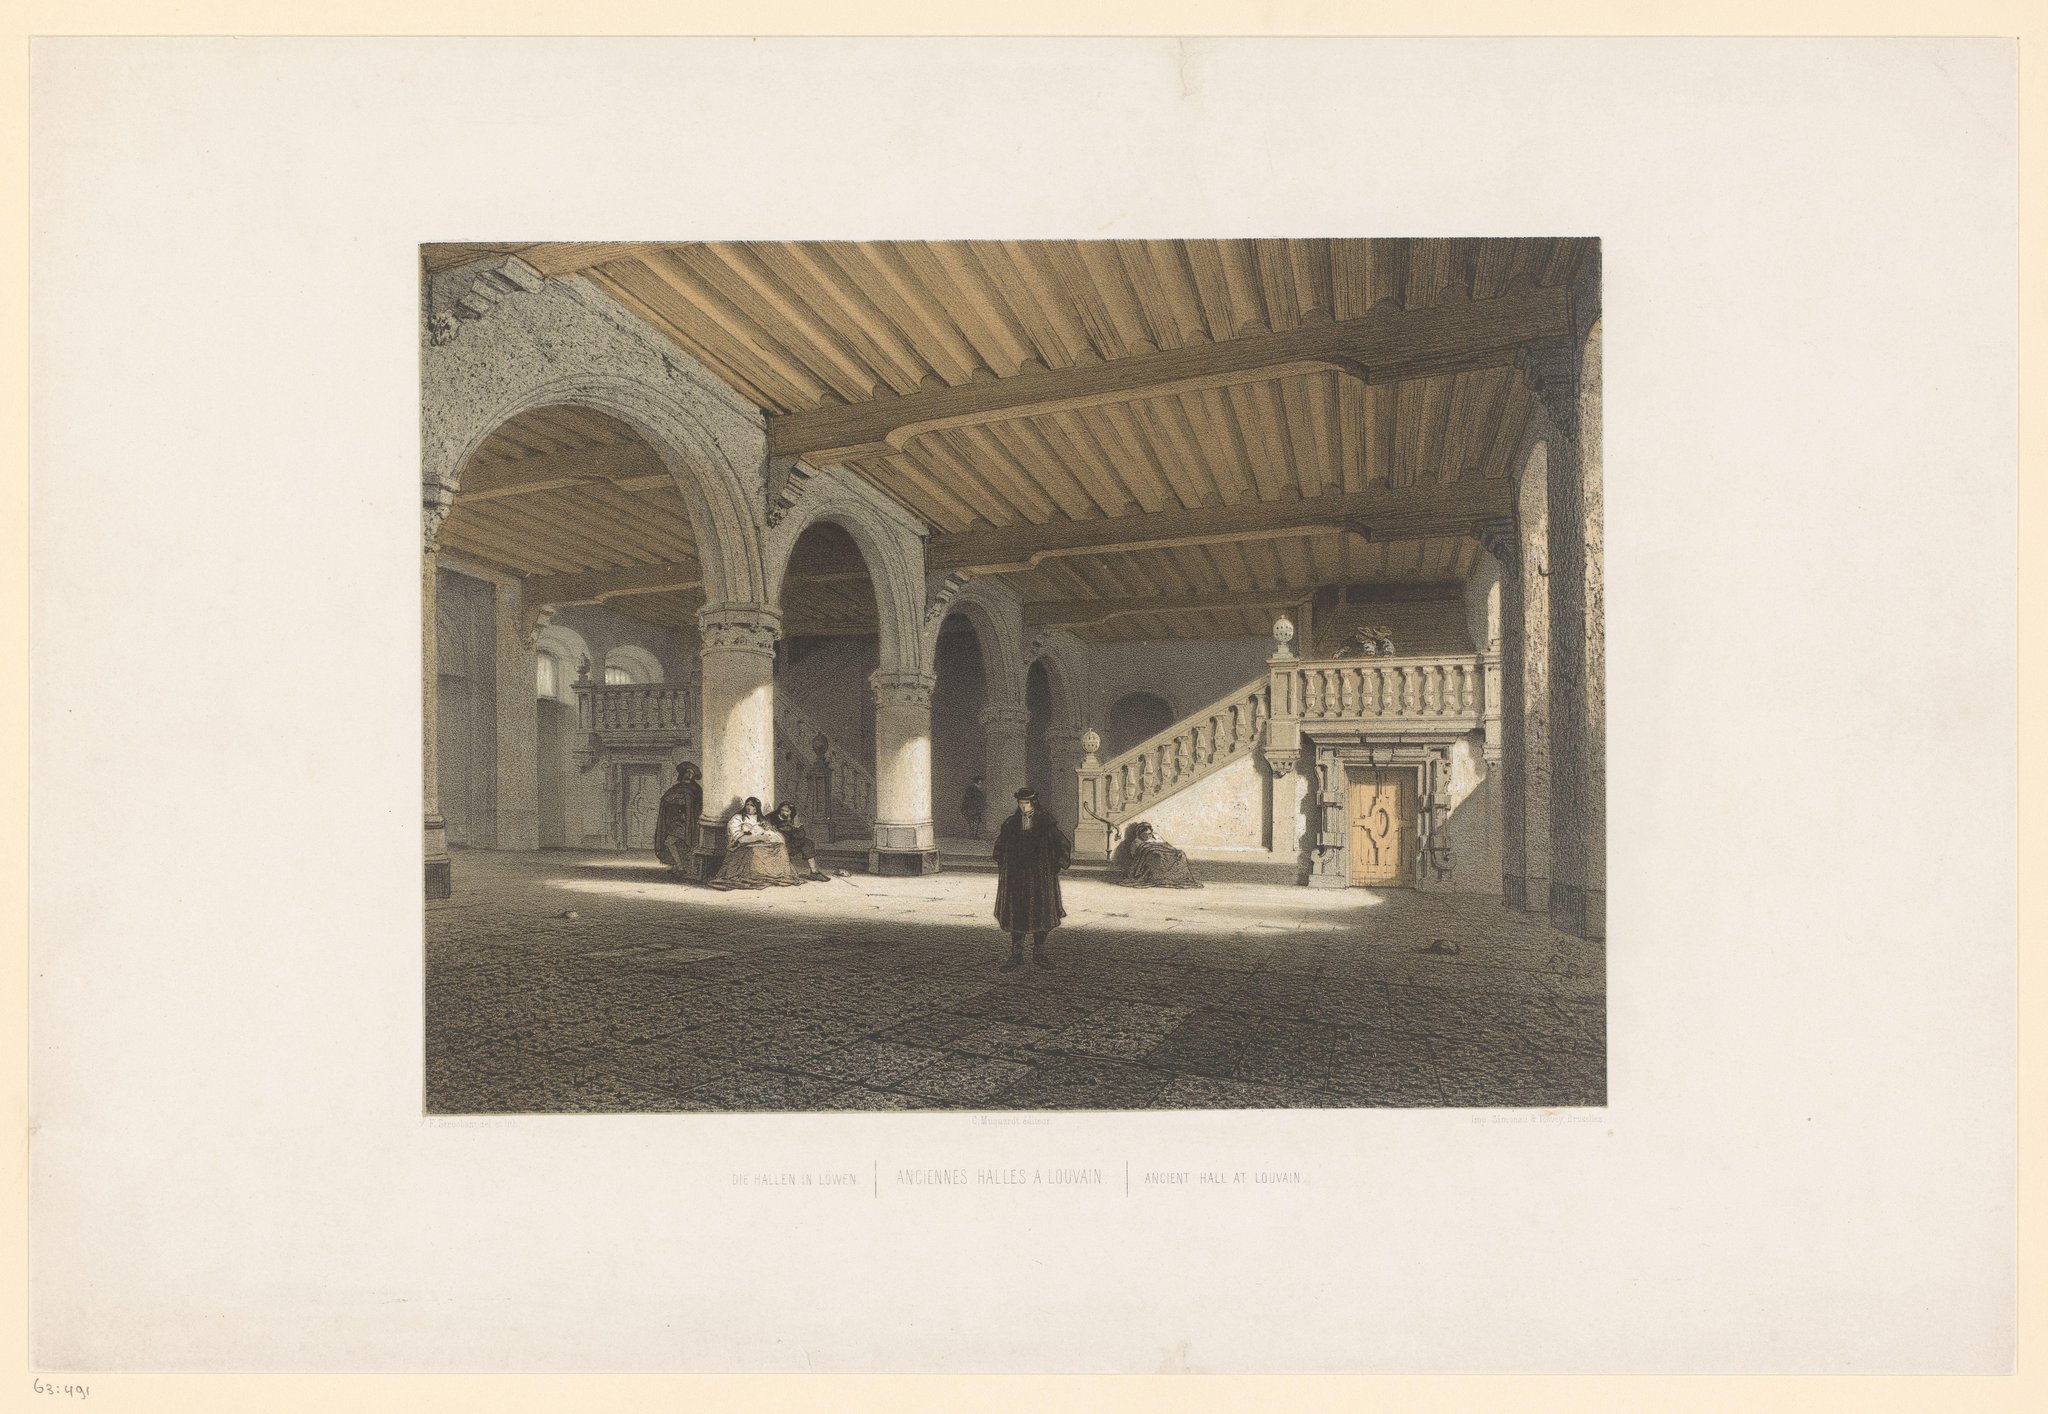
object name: print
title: Monuments d'architecture et de sculpture en Belgique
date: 1852-1878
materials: paper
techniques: lithograph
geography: brussels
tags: interior of the house, staircase, edifice, e.g.: public building, department store, louvain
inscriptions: collector's mark: Lugt 2228, collector's mark: Lugt 2760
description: Vanaf 1852 verschijnen de eerste afleveringen van deze serie, telkens in een set van drie platen voorzien van tekst door Félix Stappaerts. Later (vanaf 1854 tot en met 1878) worden deze prenten gebonden uitgegeven.